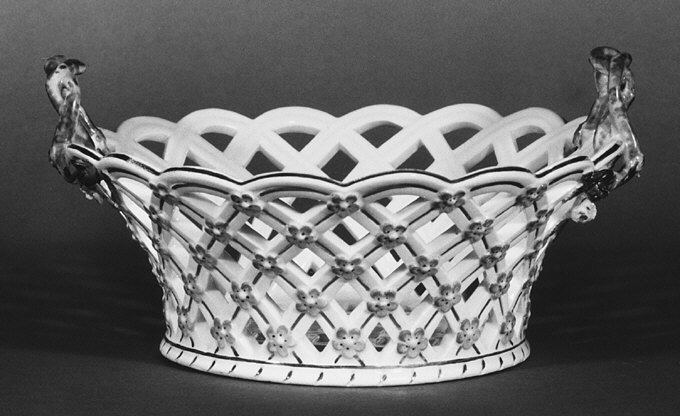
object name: basket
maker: meissen manufactory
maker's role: manufactory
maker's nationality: german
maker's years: 1710-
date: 1701-1800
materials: hard paste porcelain